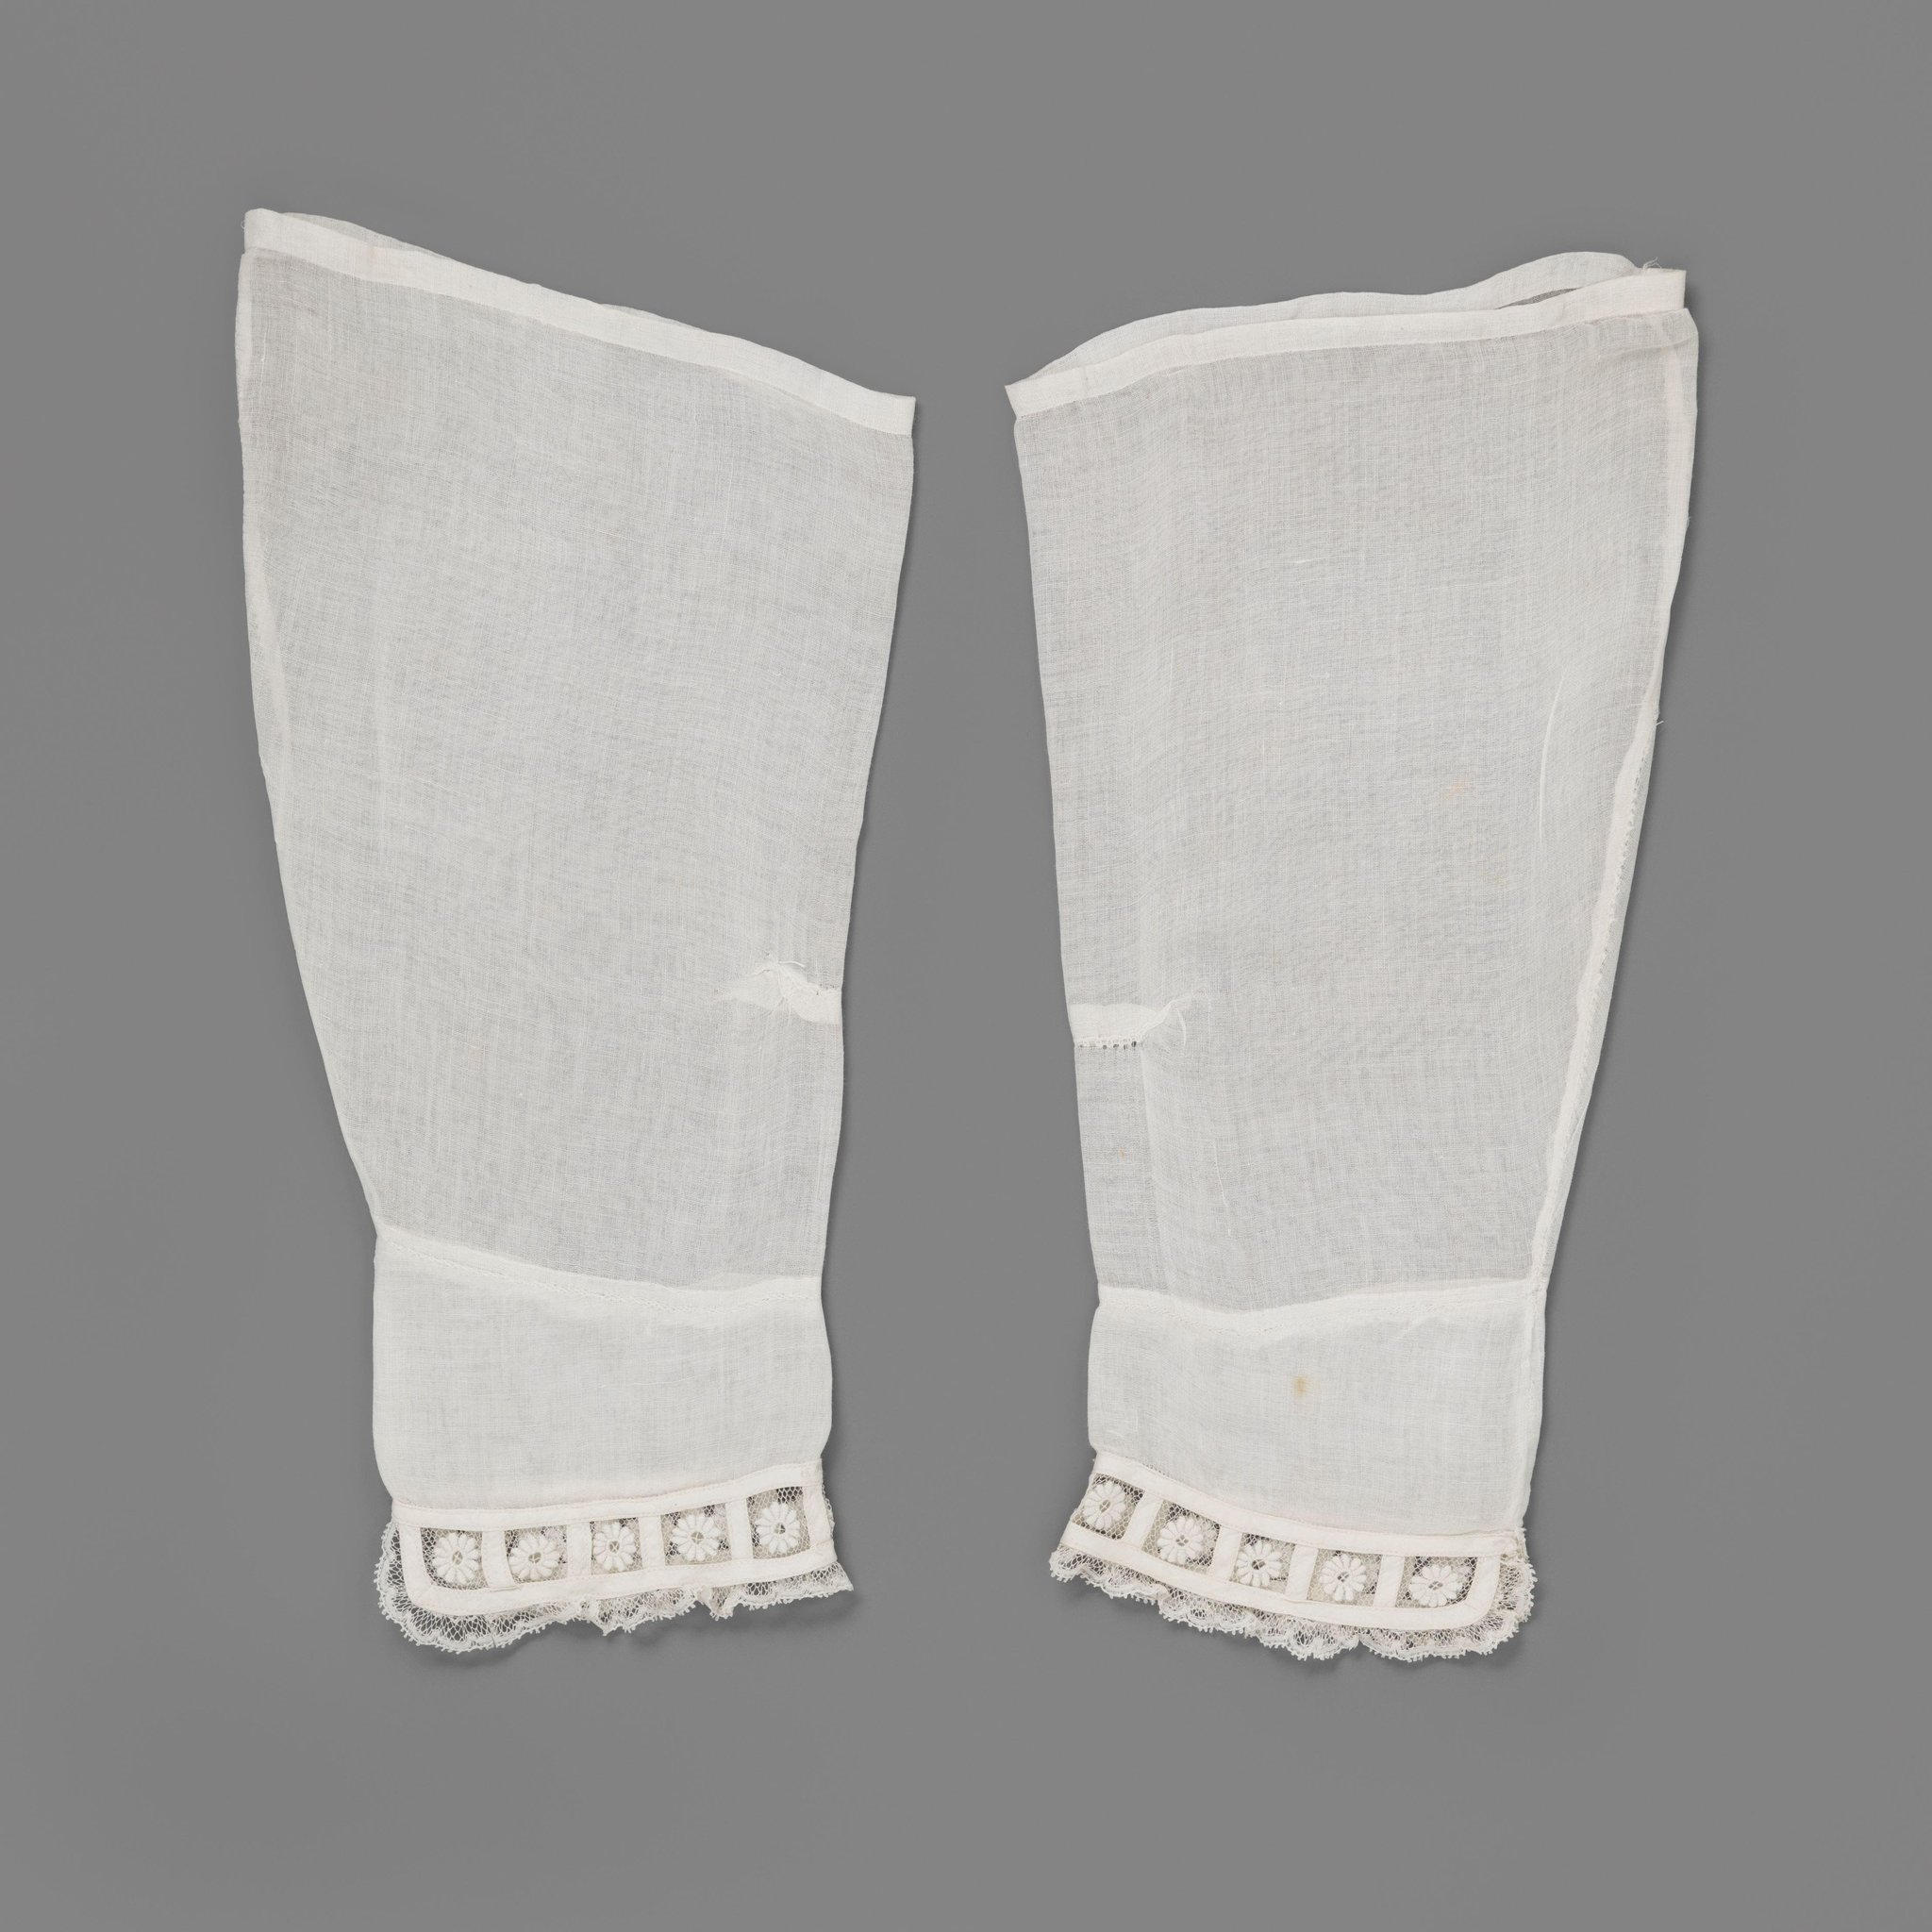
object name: womenswear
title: Ondermouw van batist met manchet van Valenciennes-kant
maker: Anonymous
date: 1880-1900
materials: textile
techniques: lace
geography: western europe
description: Ondermouw van batist met manchet van Valenciennes-kant.